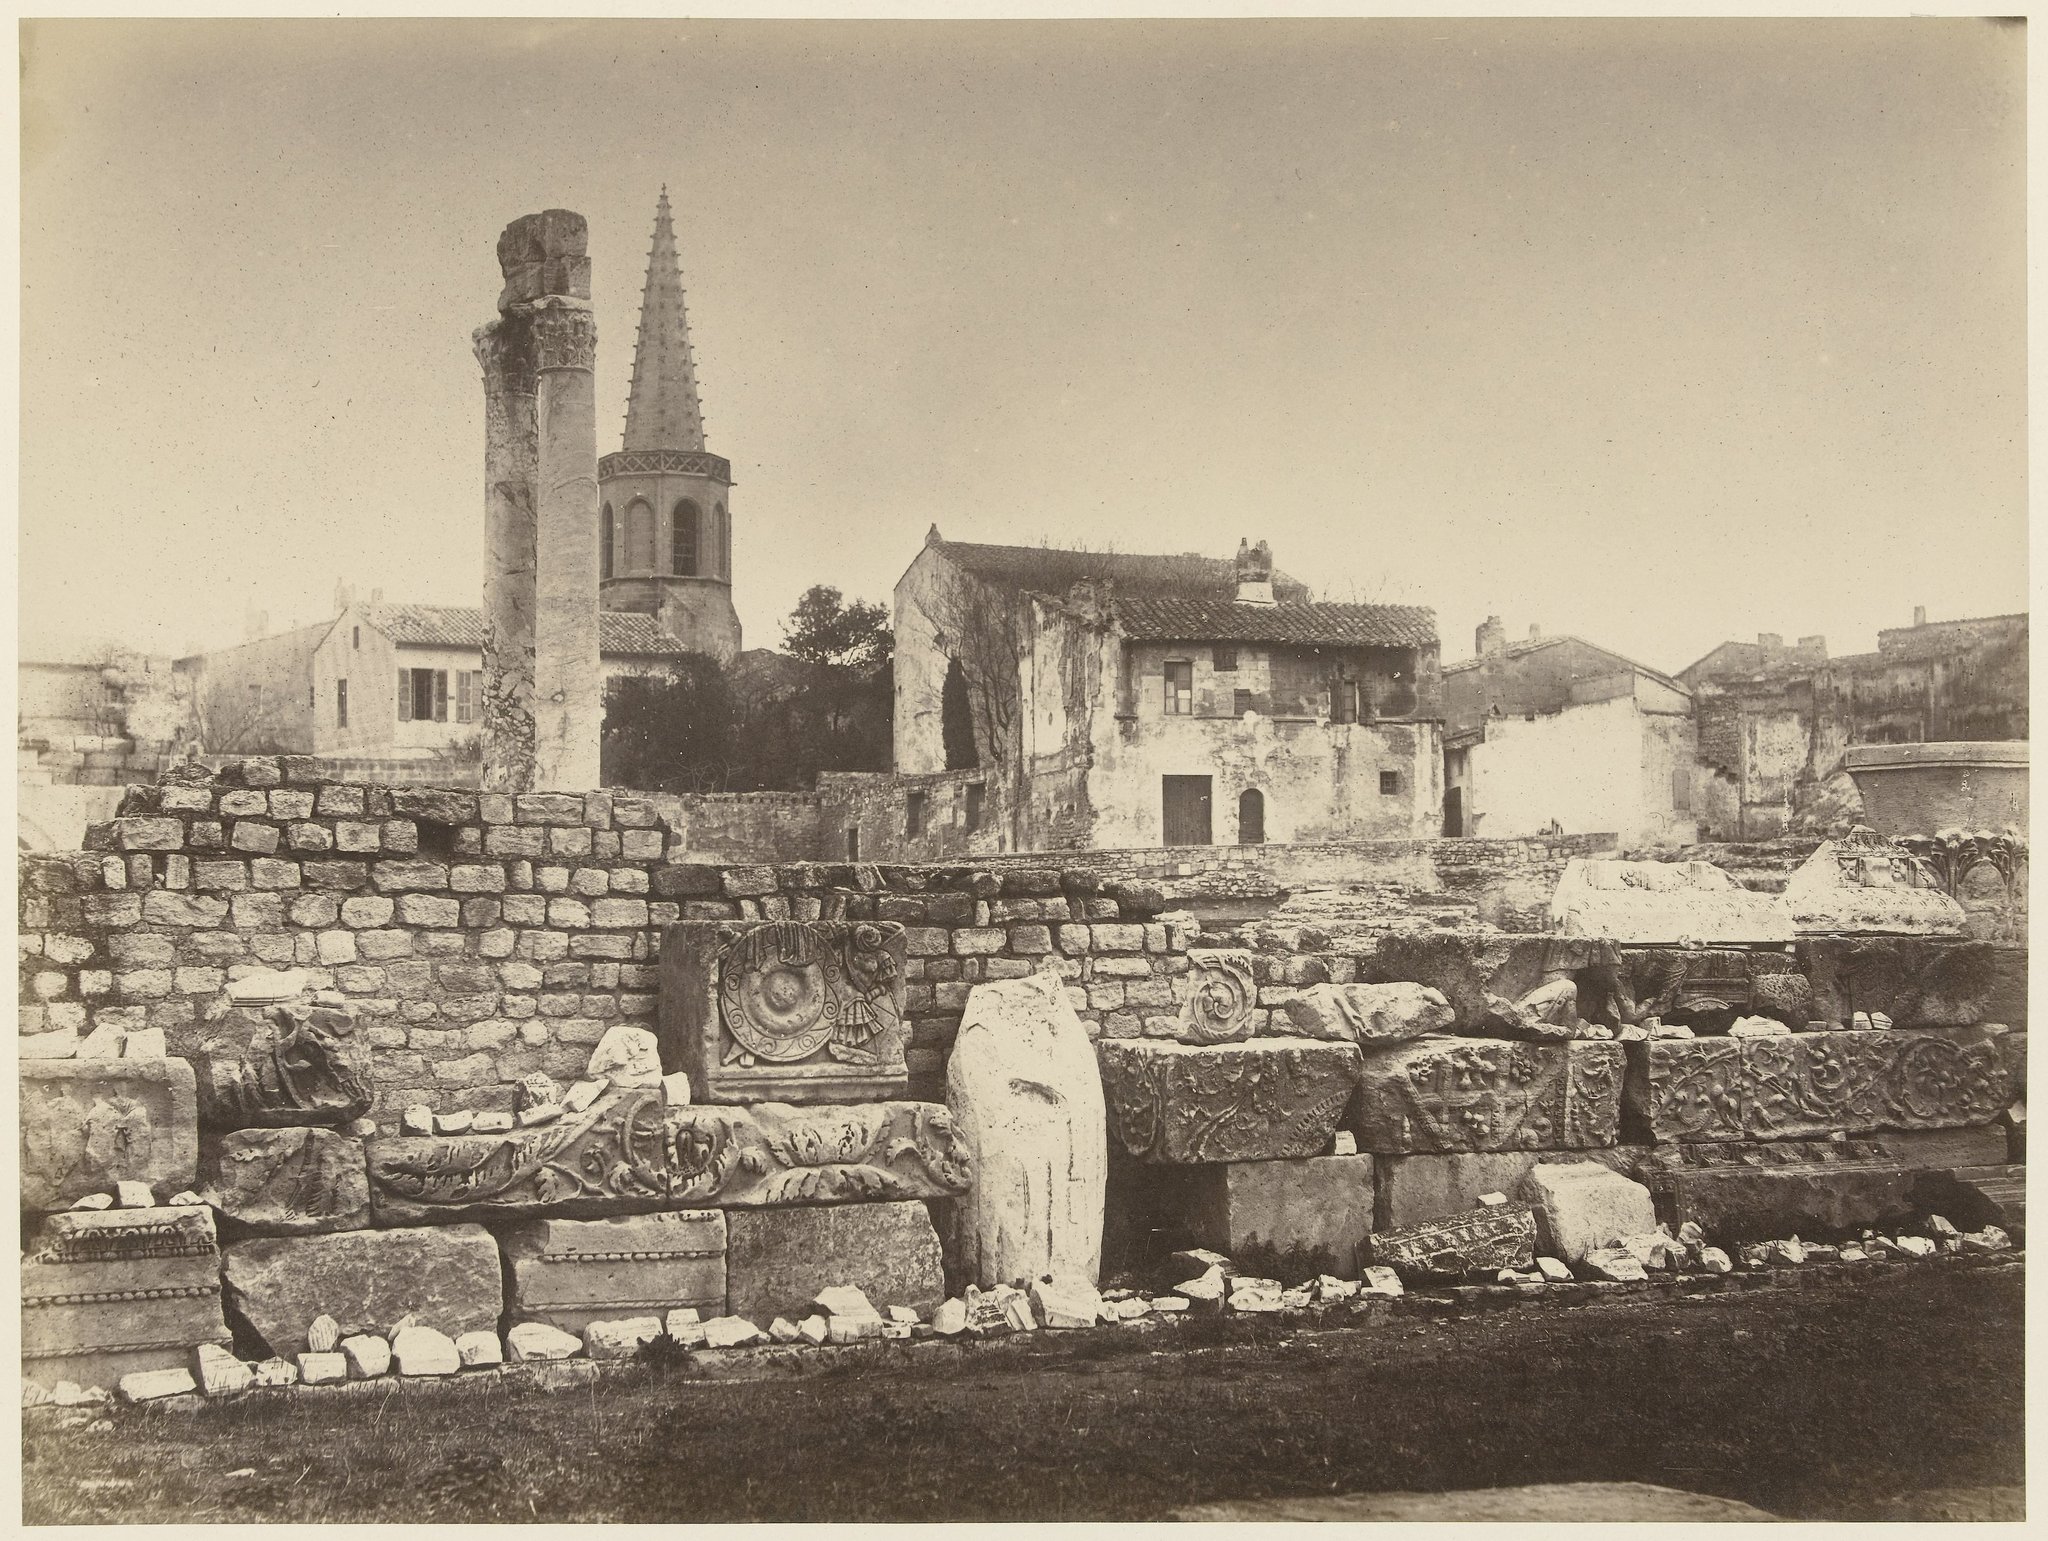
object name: photograph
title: Brokstukken van het amfitheater van Arles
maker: charles lenormand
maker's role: fotograaf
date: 1875-1885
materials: cardboard, paper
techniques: albumen print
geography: arles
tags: ruin of a building ~ architecture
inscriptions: stamp: ‘CH. LENORMAND/ PHOT.’